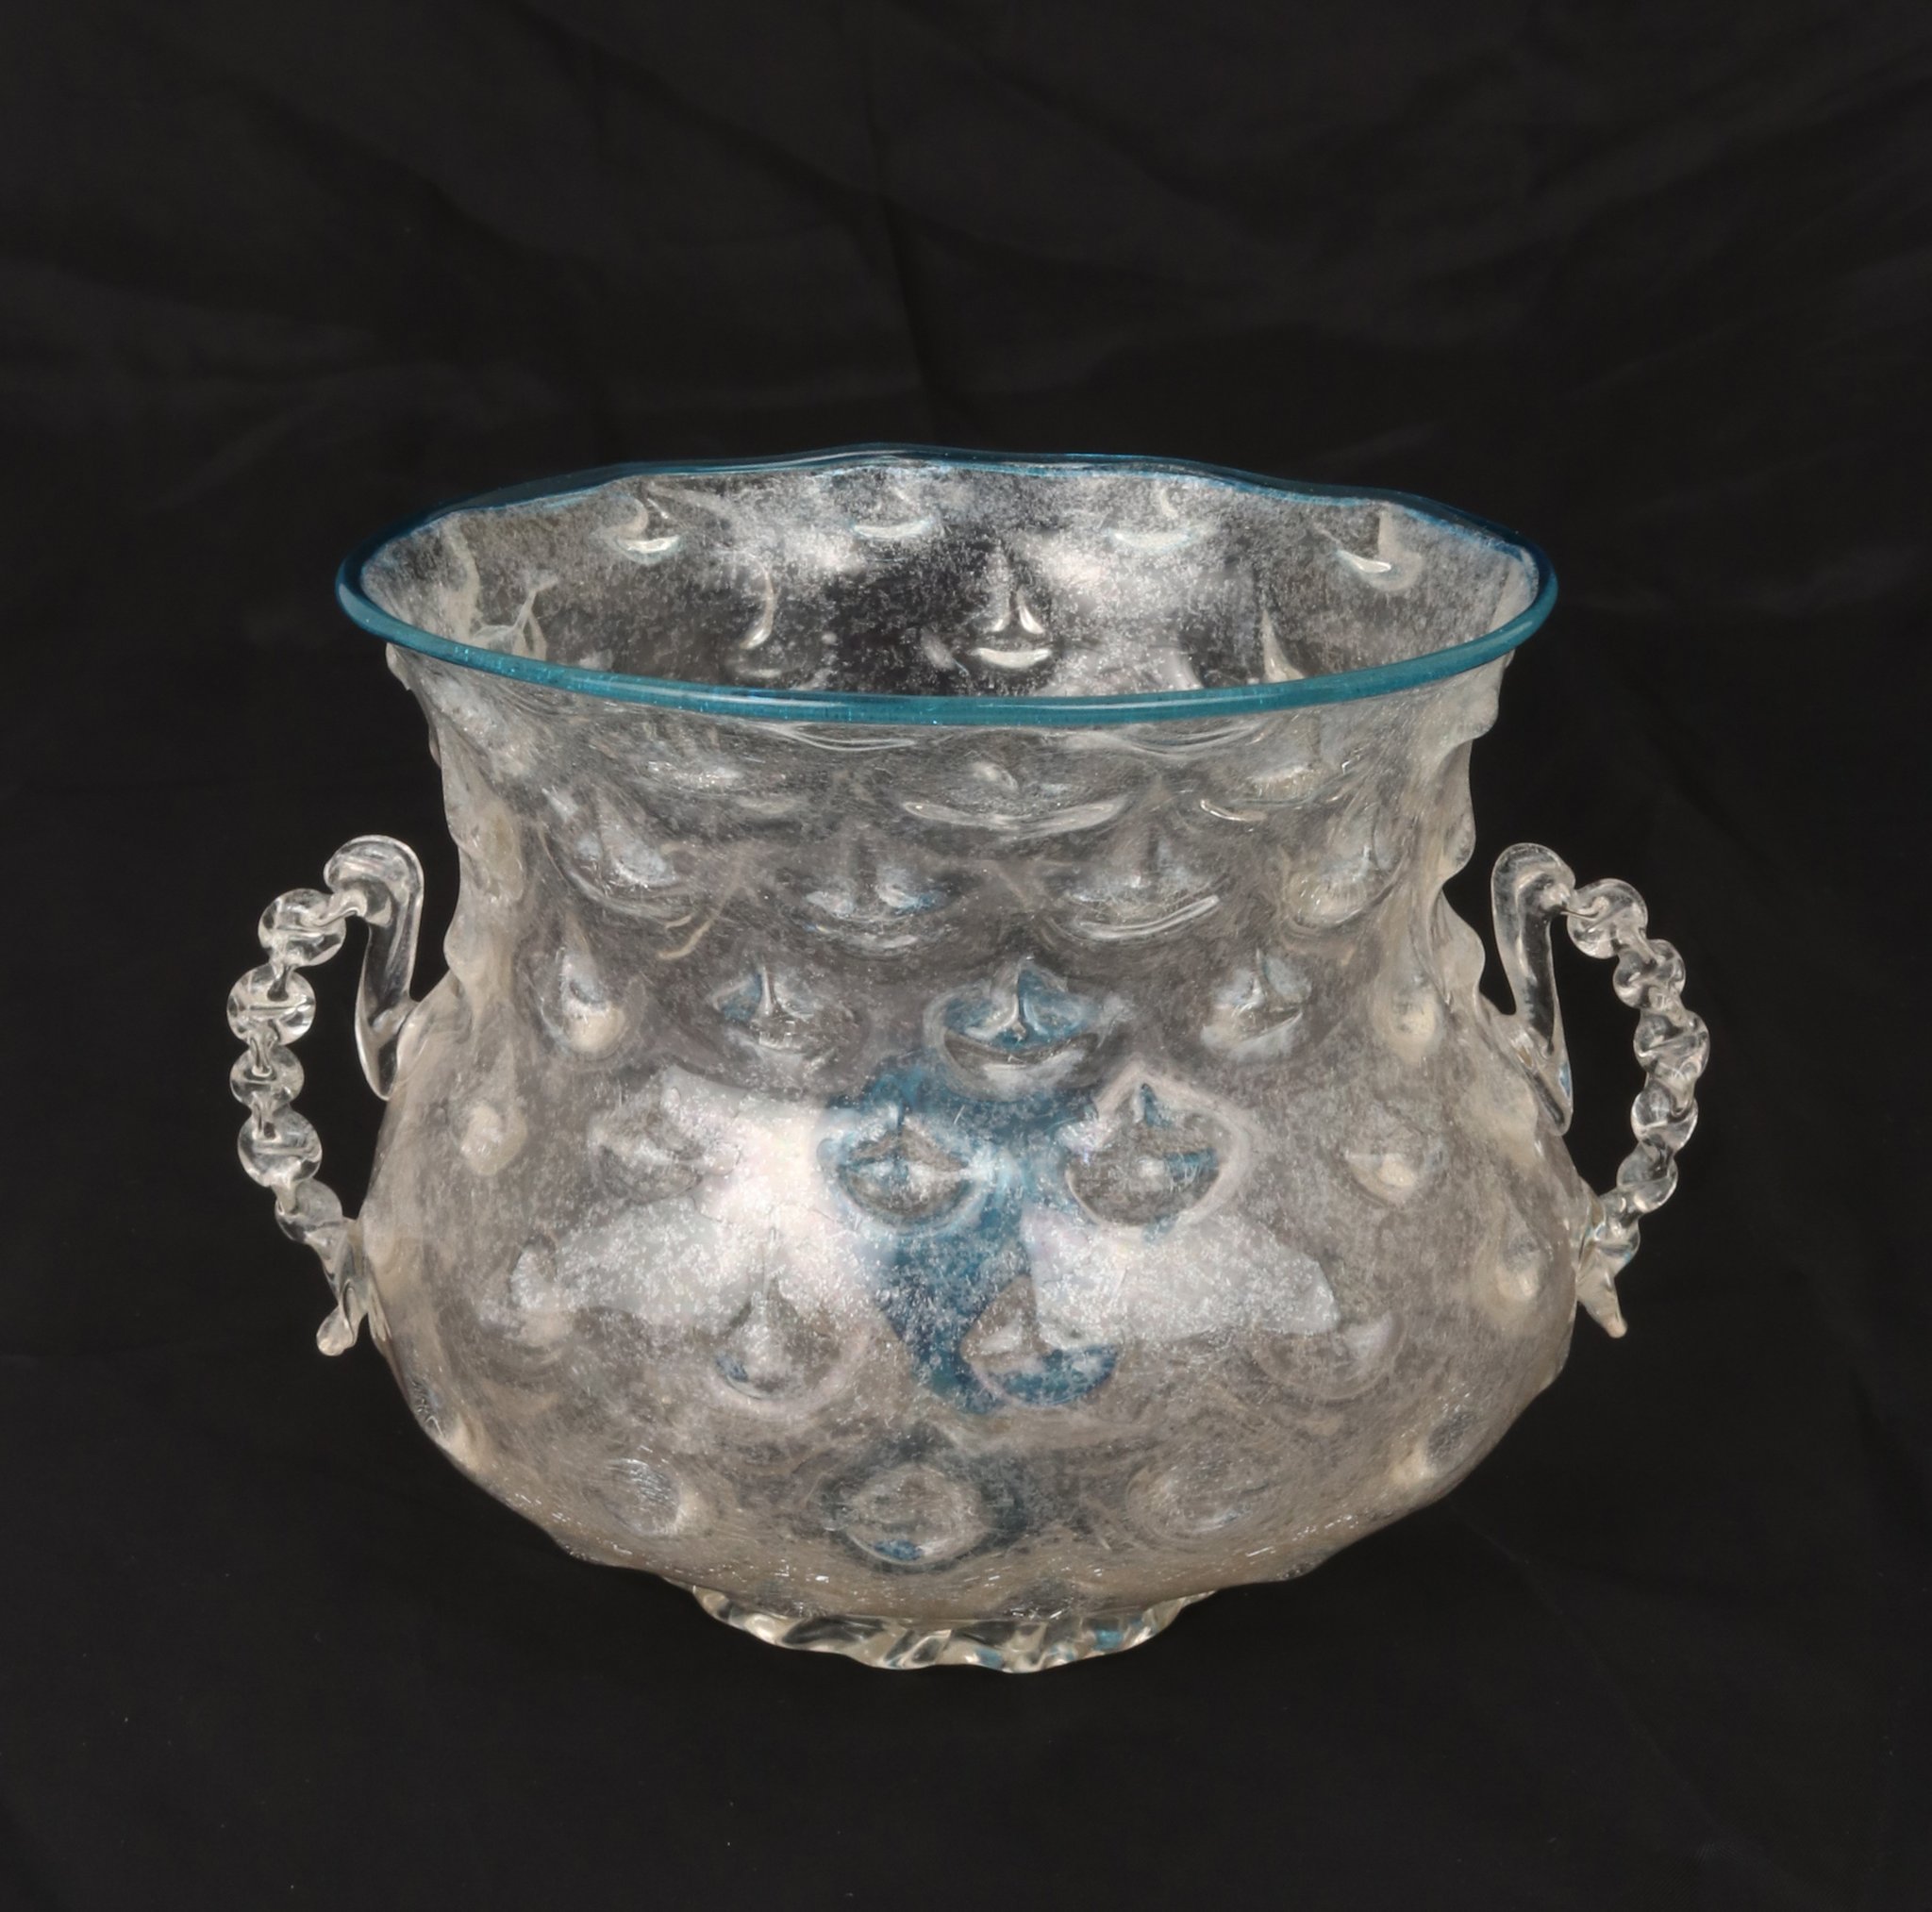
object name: bowl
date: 1601-1700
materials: glass